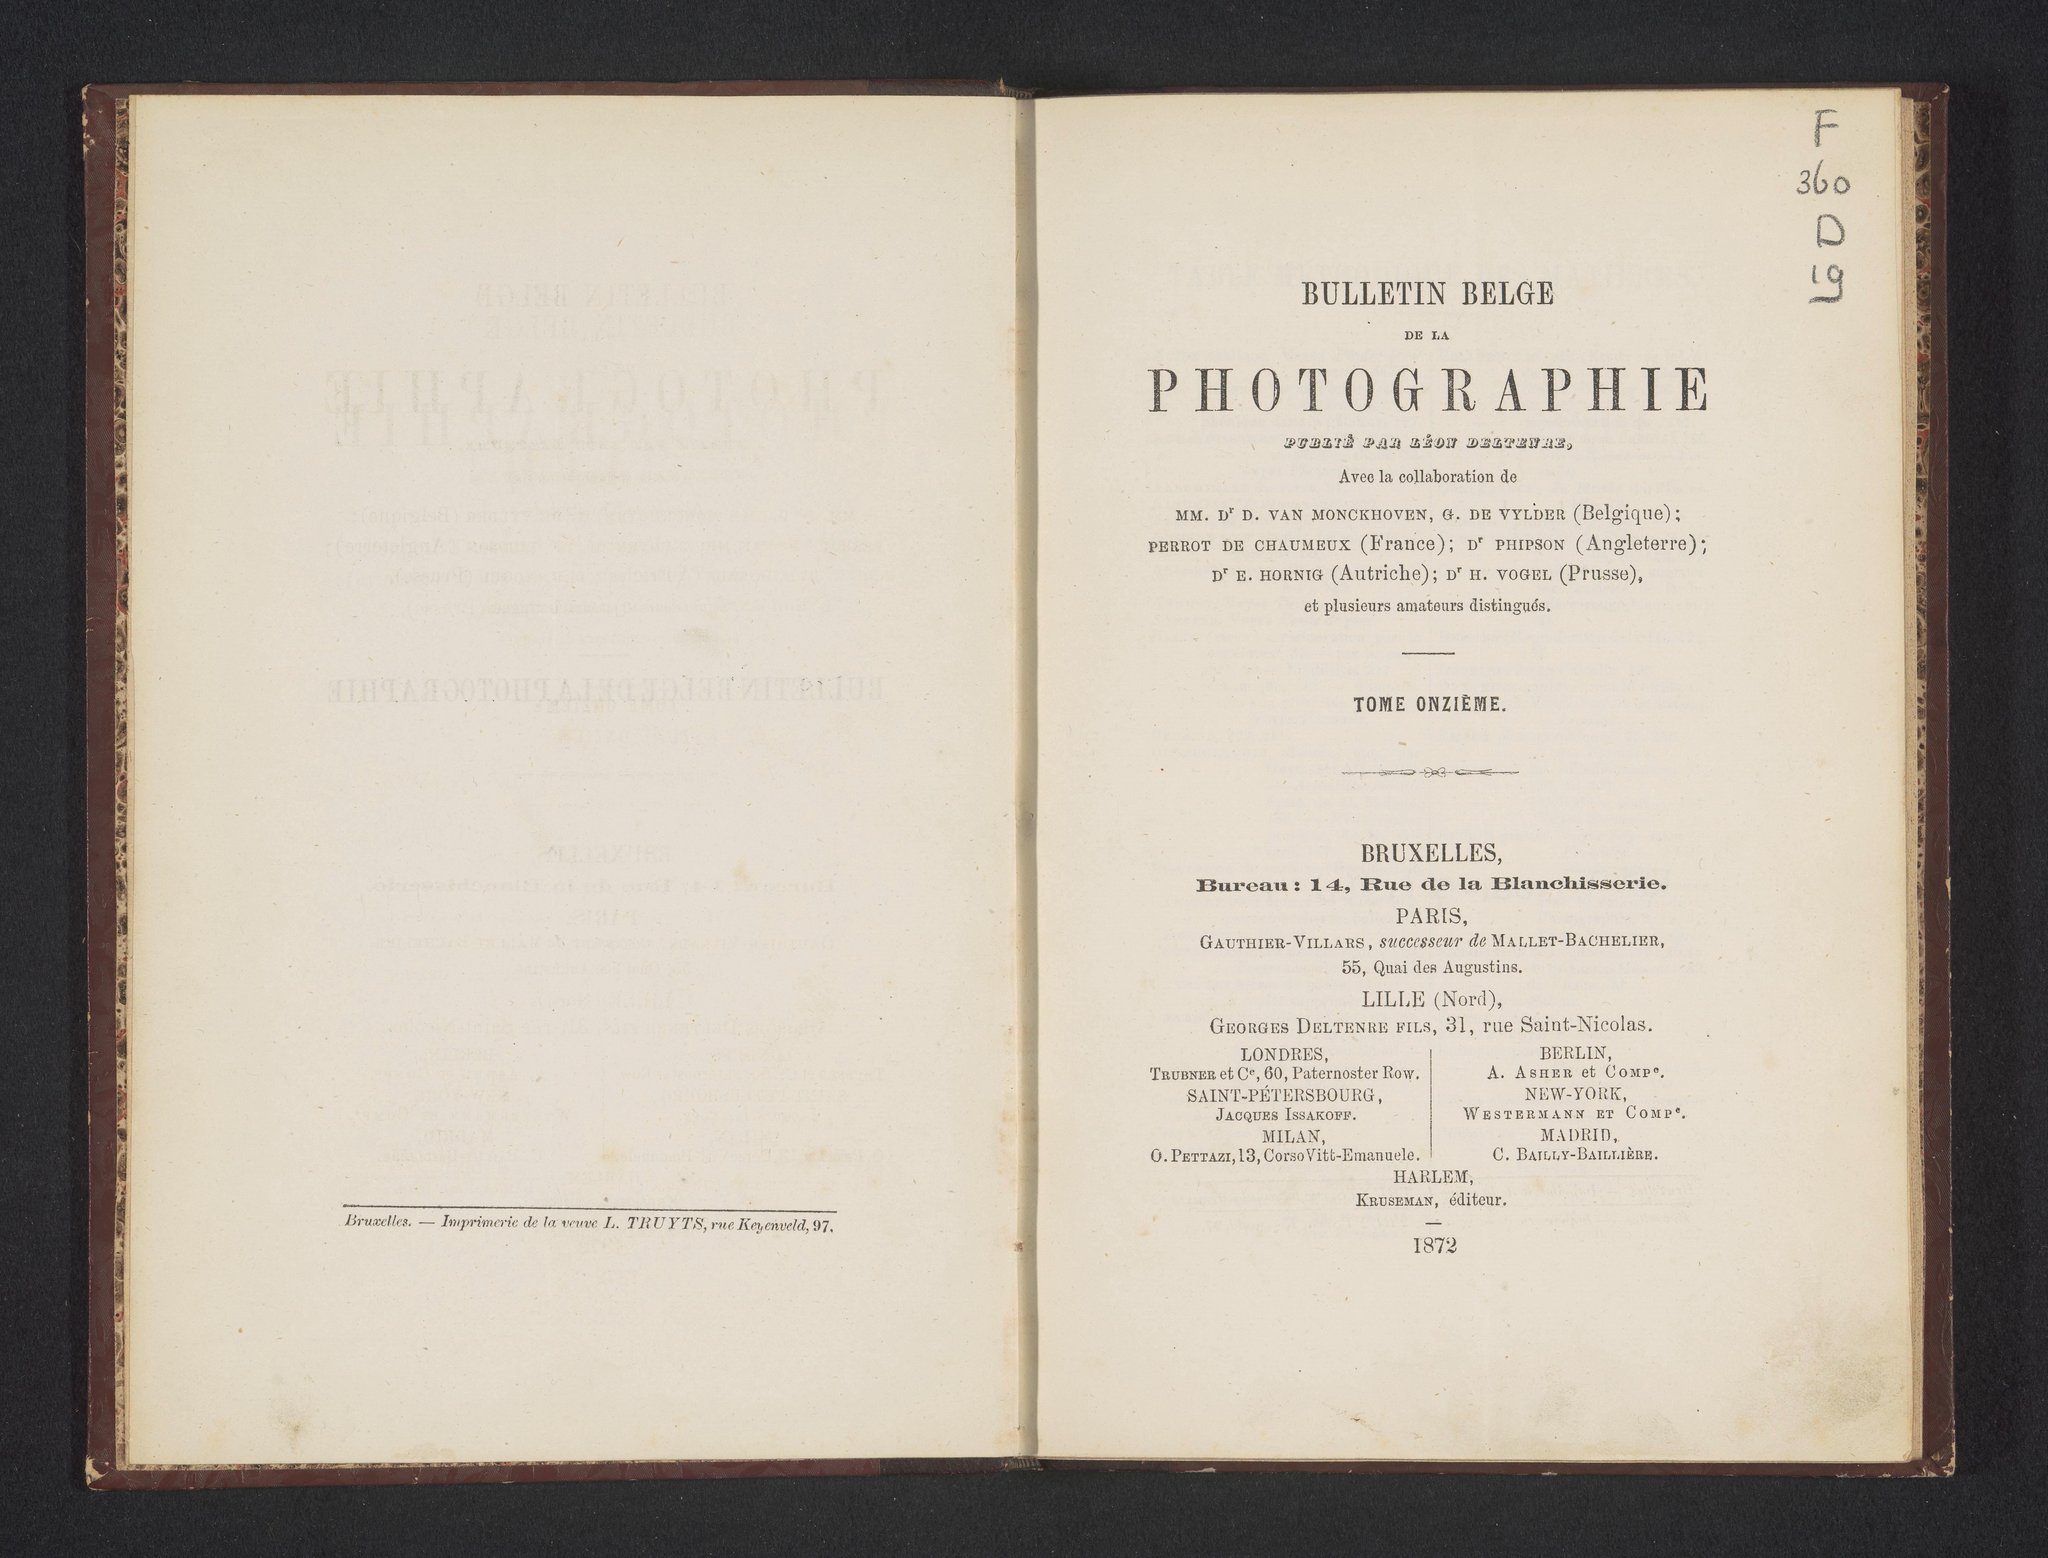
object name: magazine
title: Bulletin belge de la photographie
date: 1872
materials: cardboard, leather, linen, paper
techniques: decorated paper, printing, marbled paper, woodburytype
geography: brussels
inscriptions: annotation: ‘OCT/ 1997’